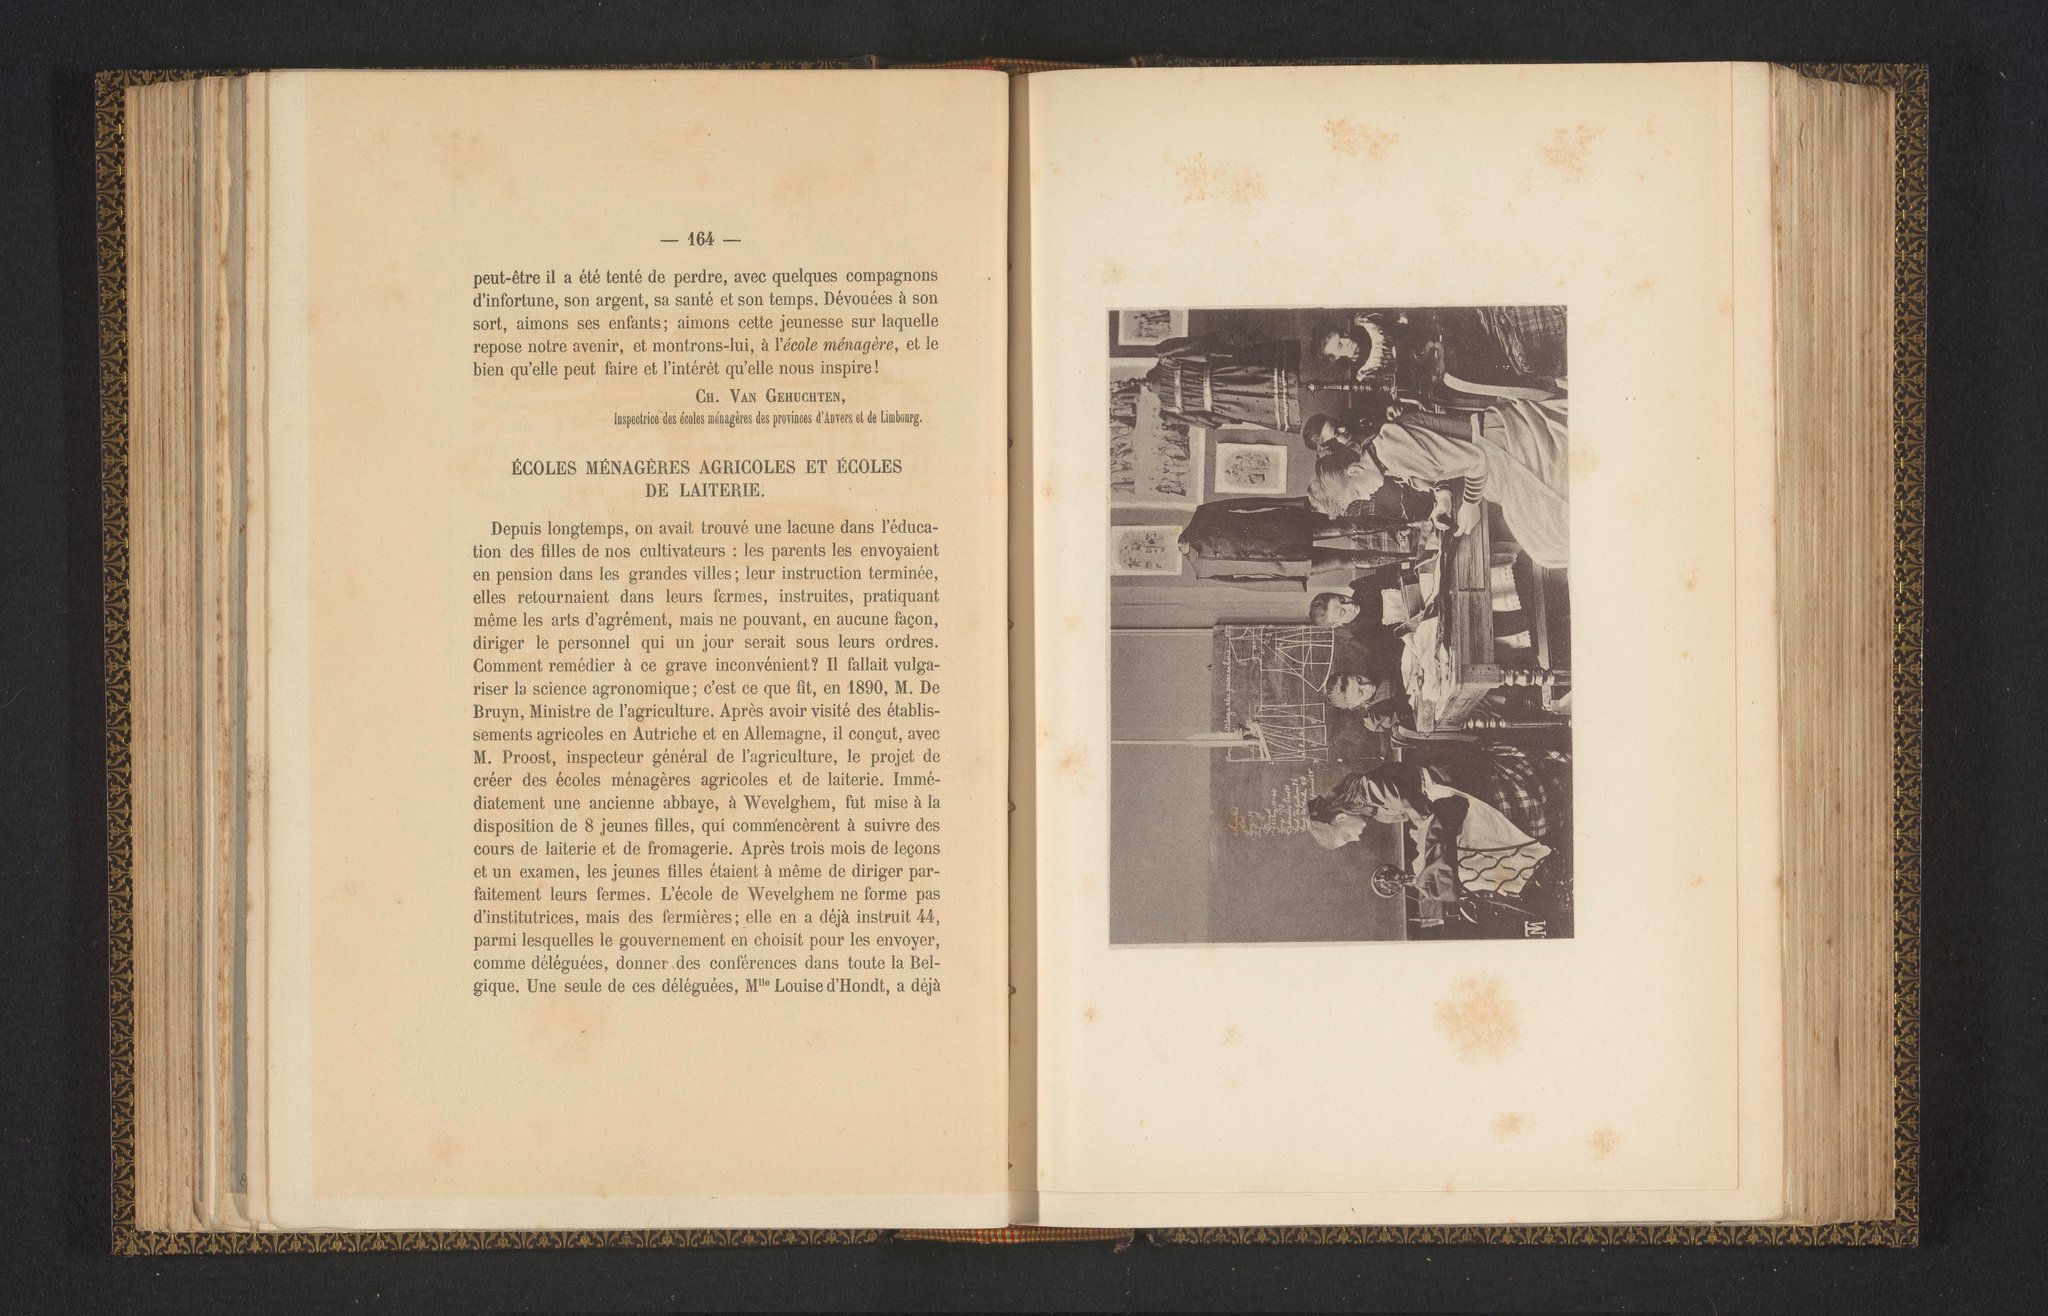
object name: page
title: Gezicht op een schoolklas waar een naailes aan de gang is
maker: Anonymous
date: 1888-1893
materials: paper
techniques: photograph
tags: sewing, elementary school; class, form